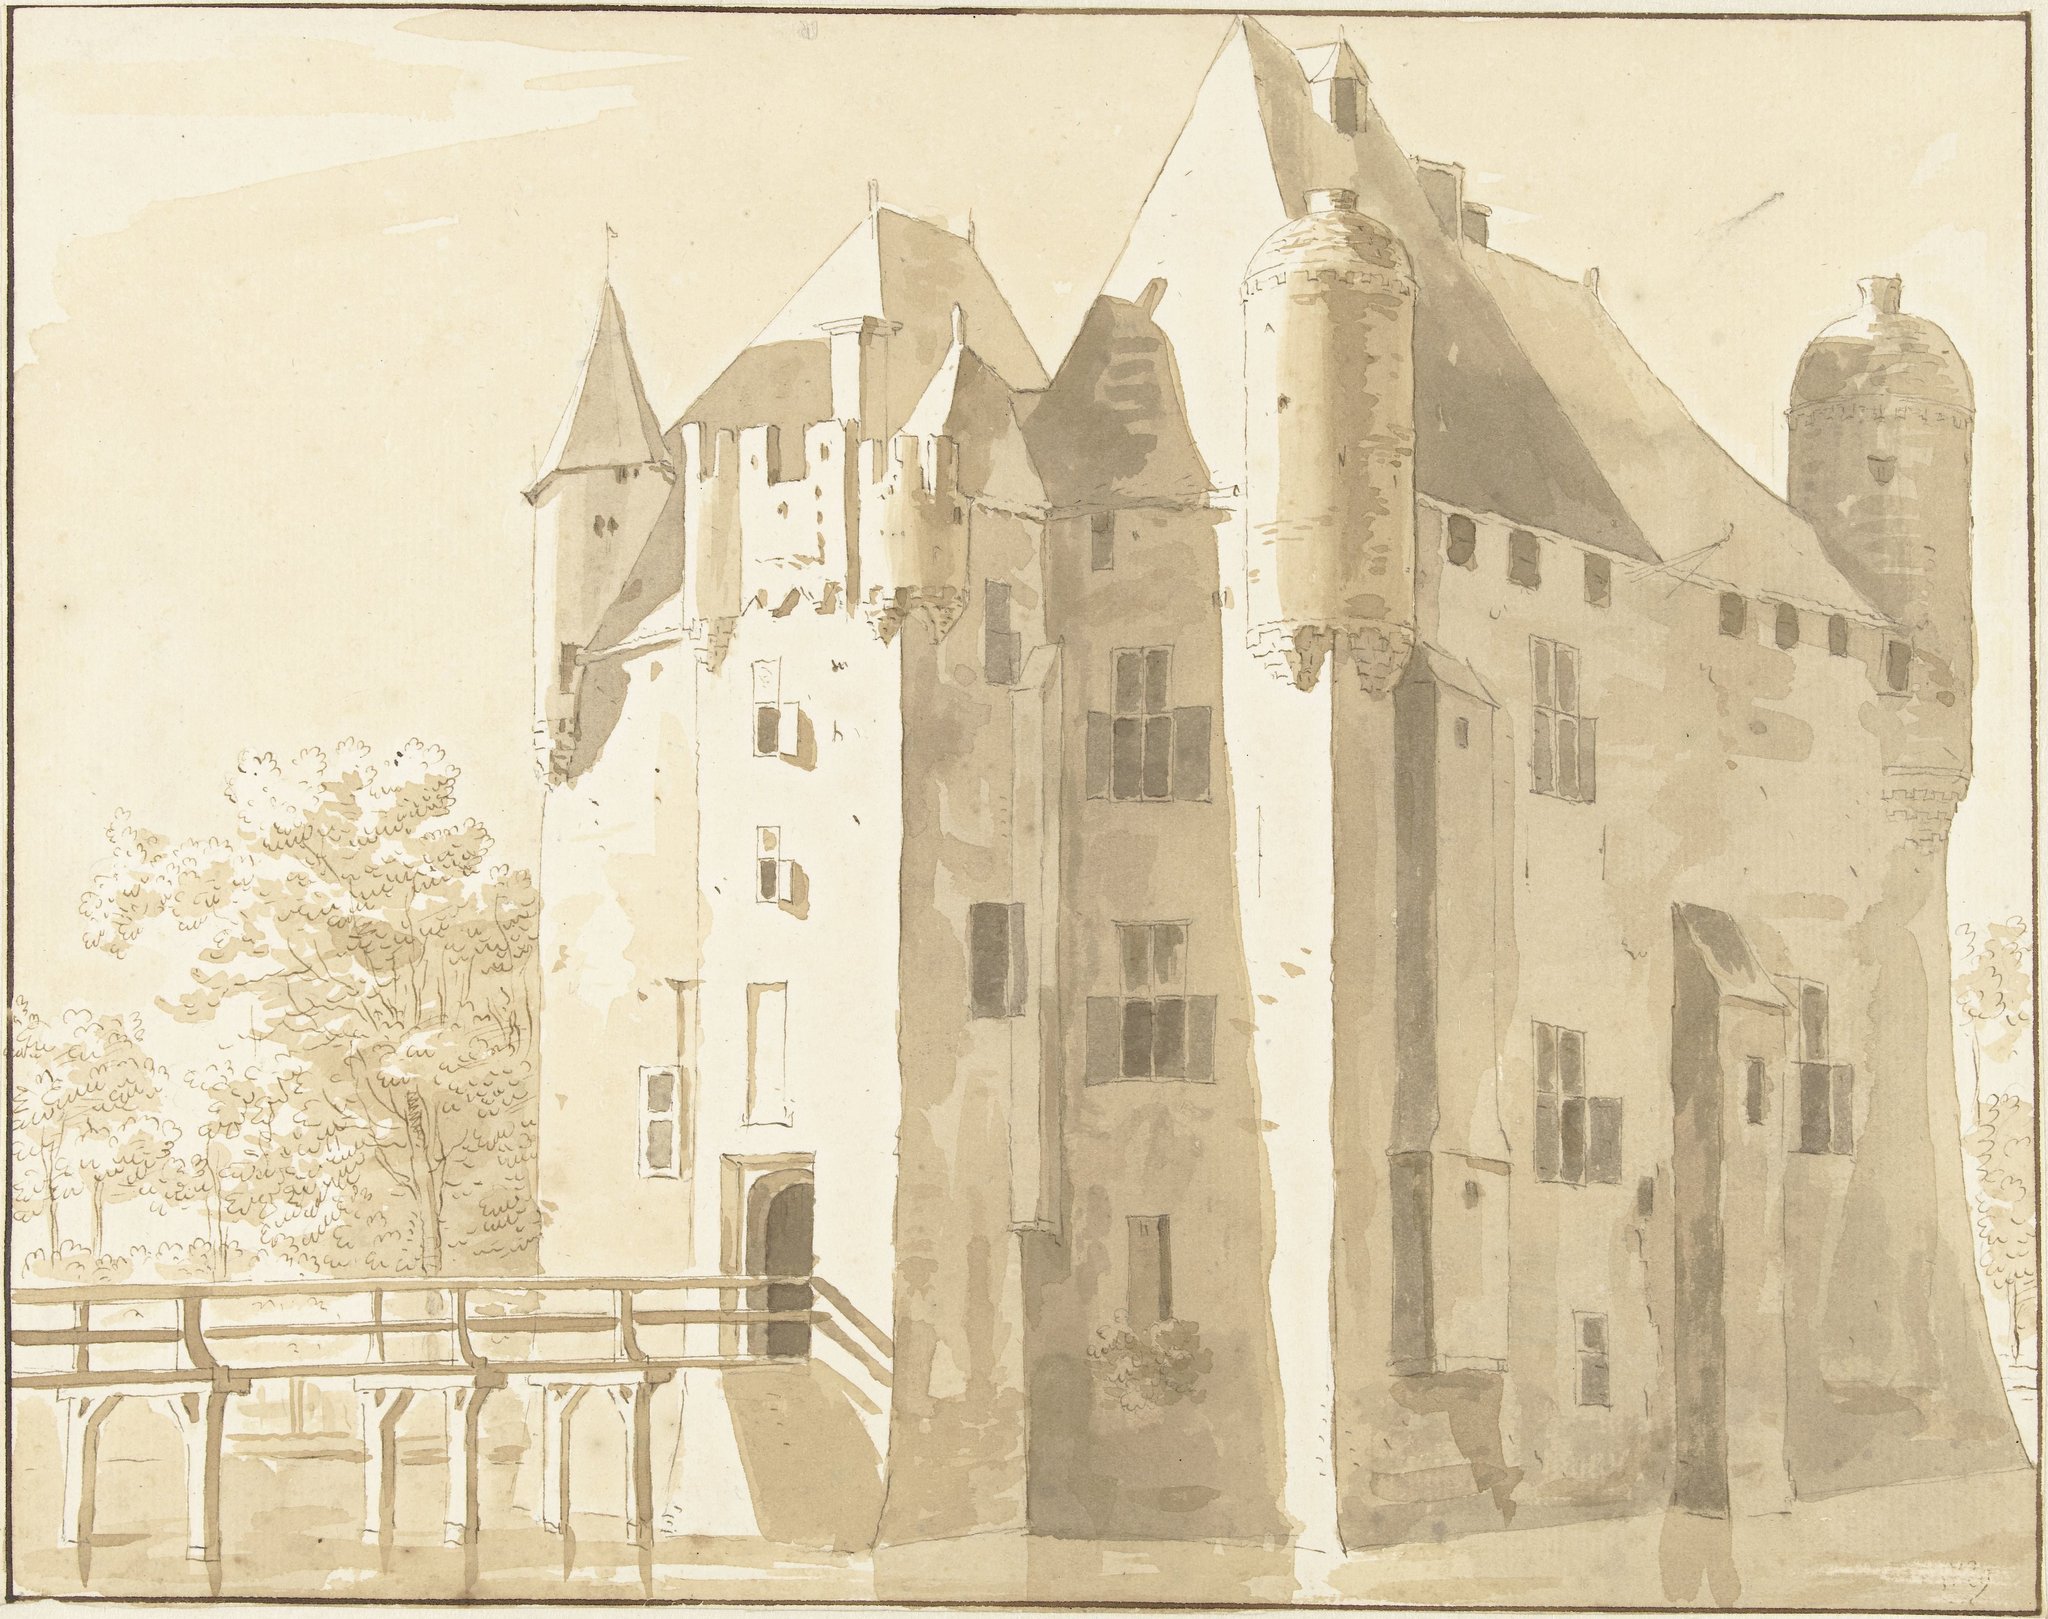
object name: drawing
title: Kasteel Frissestein te Herwijnen, achterzijde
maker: cornelis pronk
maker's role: draughtsman, painter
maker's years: 1691-1759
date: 1701-1759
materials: ink, paper, pencil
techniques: brush, pen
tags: castle